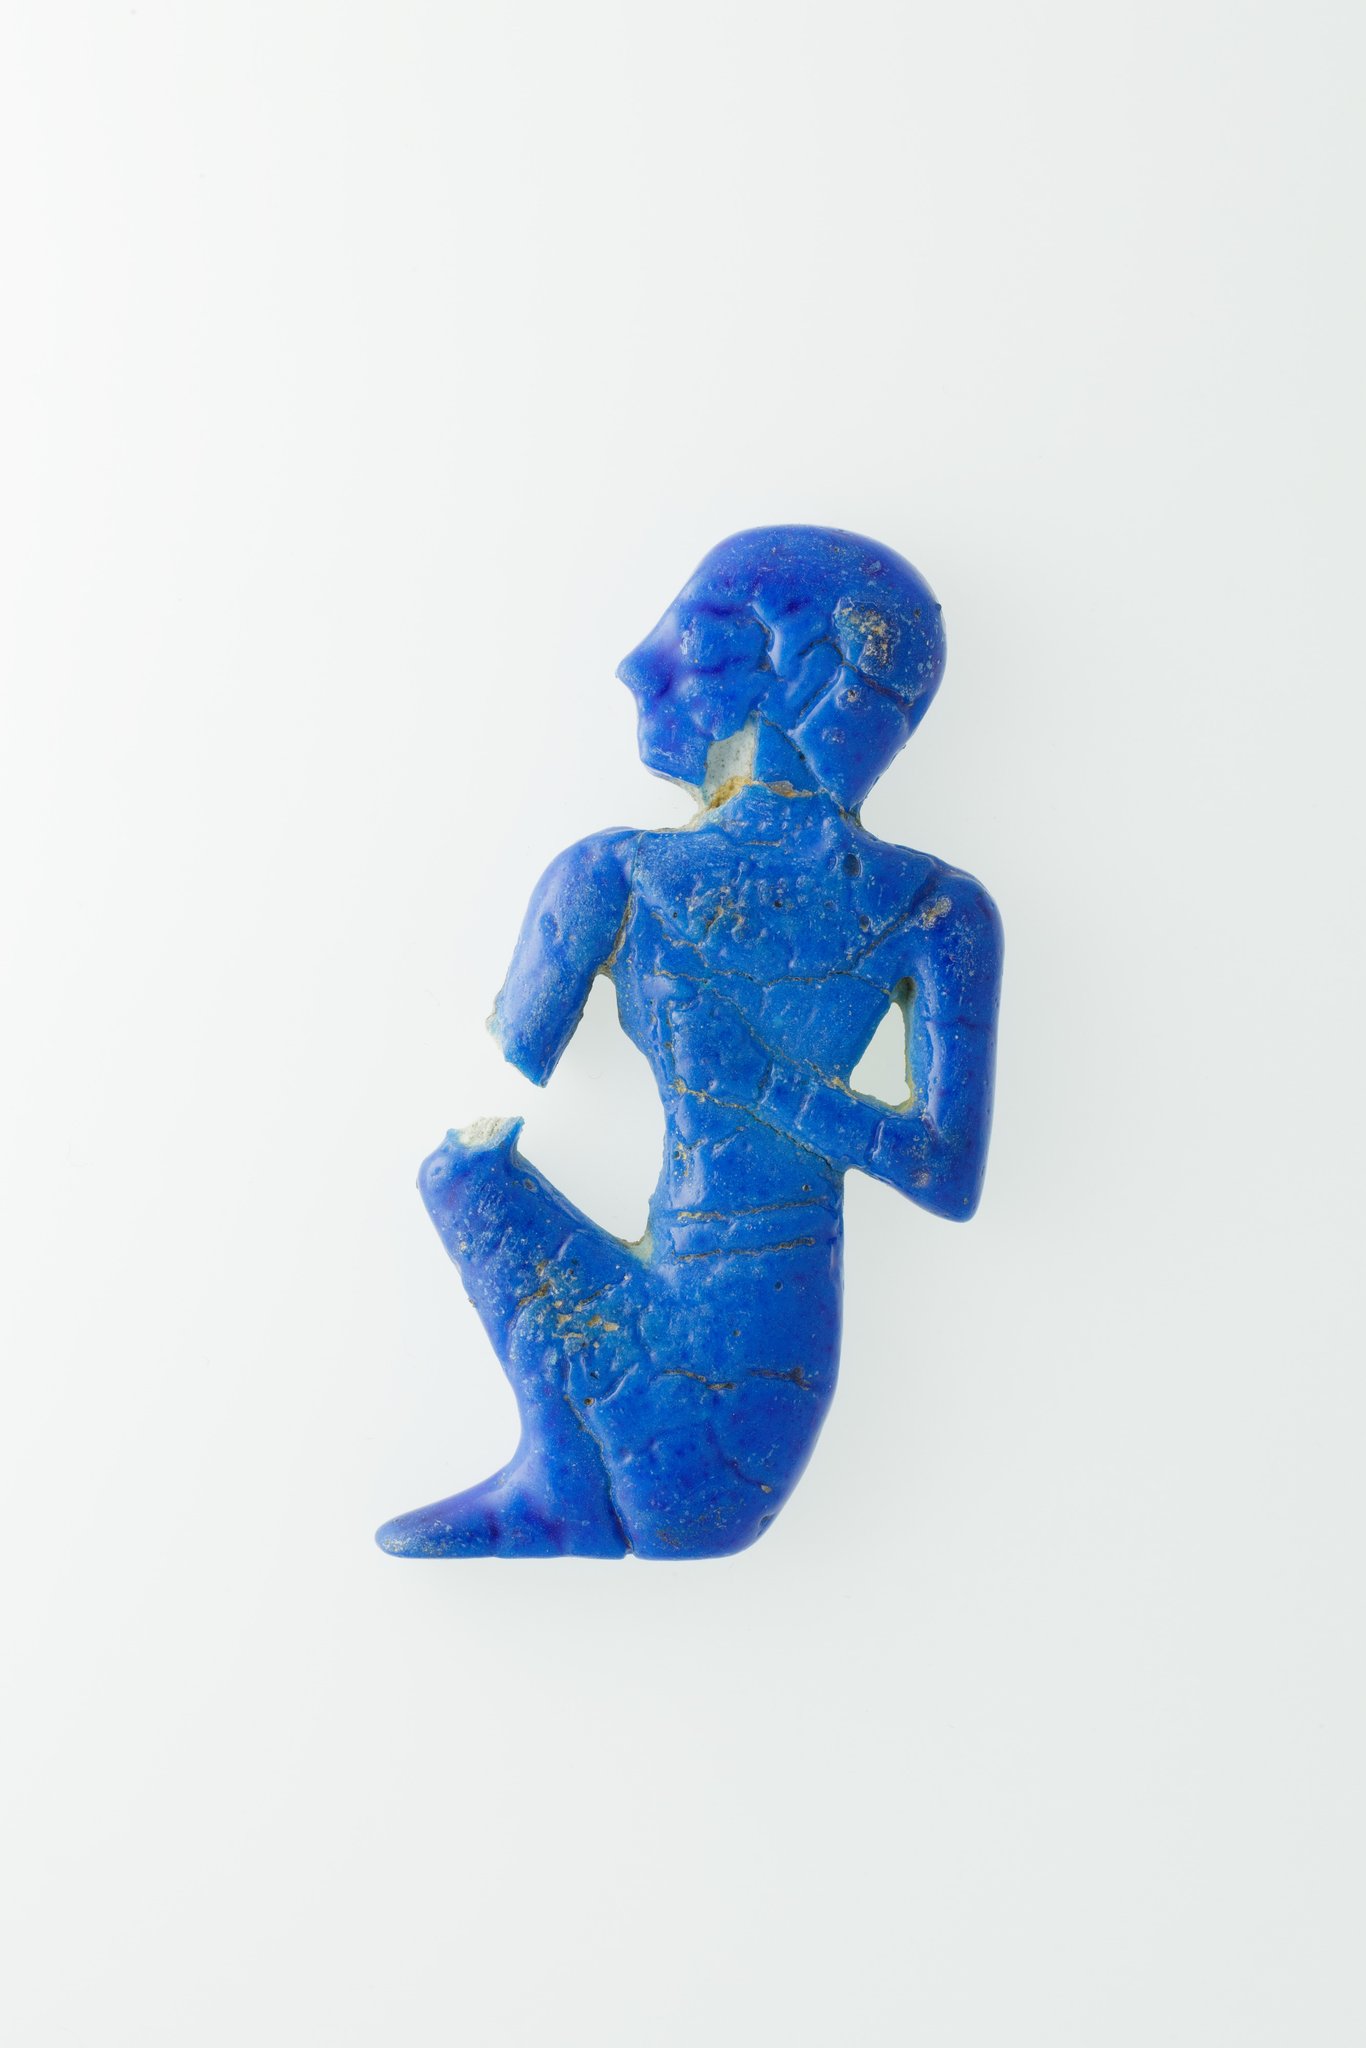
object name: inlay, hieroglyph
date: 664-610 BCE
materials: faience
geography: egypt